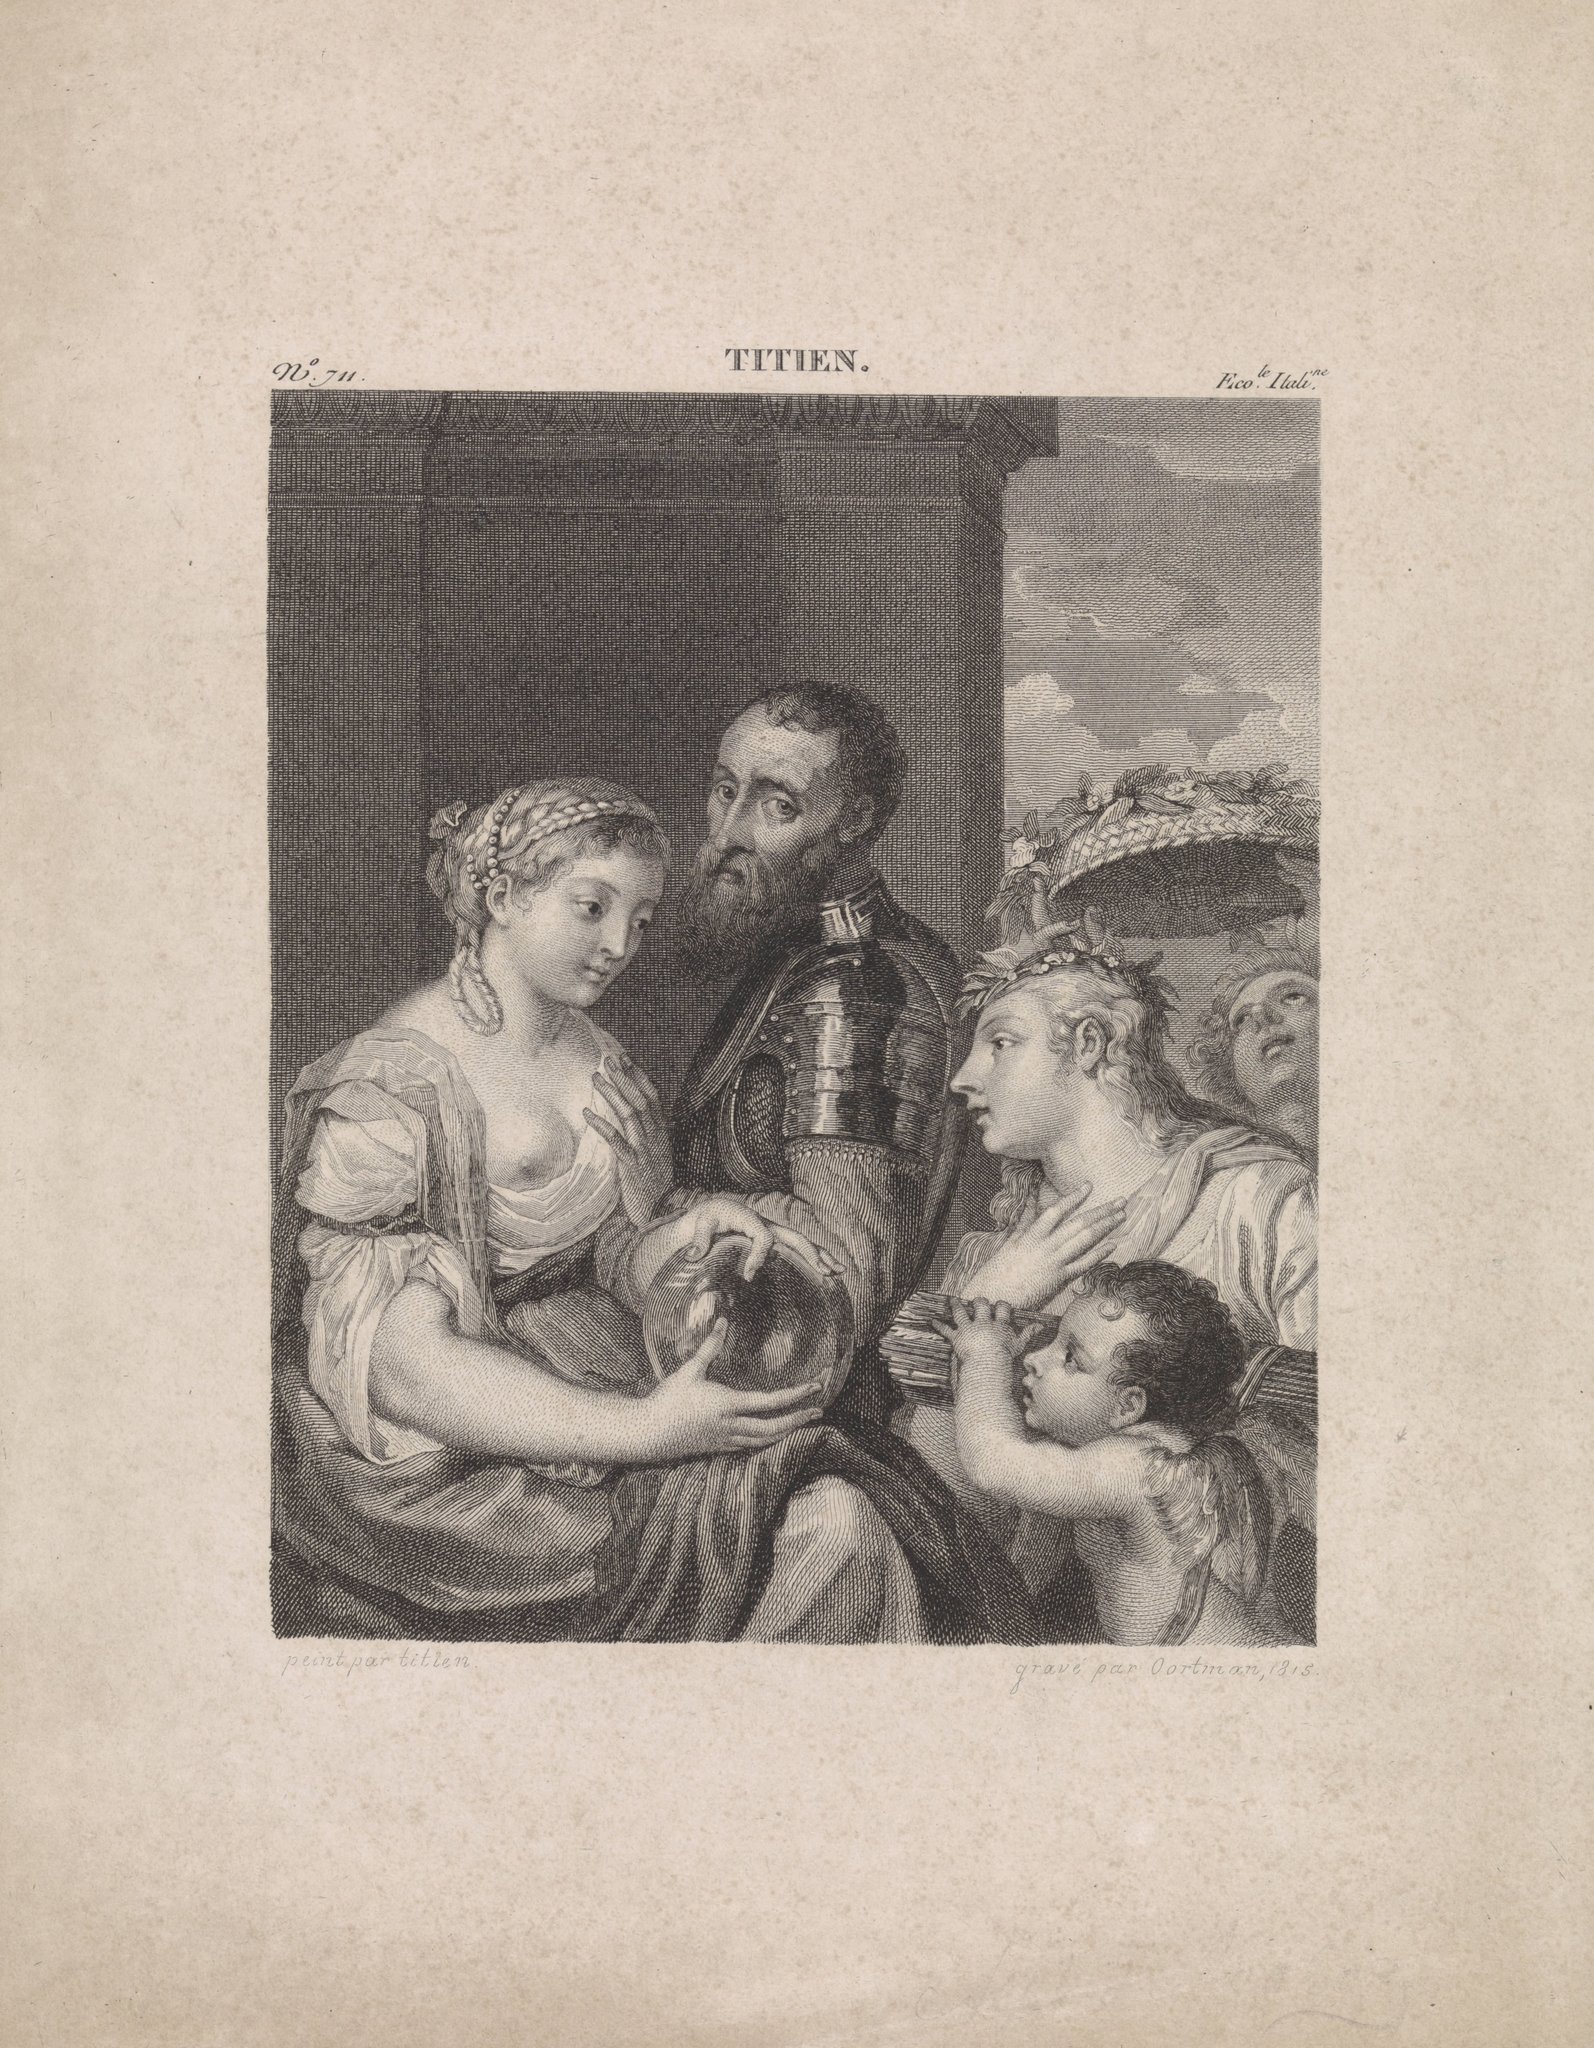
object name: print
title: Allegorie van Alfonso d'Avalos, Marchese del Vasto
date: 1815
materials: paper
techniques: etching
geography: paris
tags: ischia, isola d'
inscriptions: collector's mark: Lugt 2228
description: Gemaakt voor de afdeling Italiaanse school van: Galerie du Musée Napoléon. Parijs: Filhol, 1804-1815.